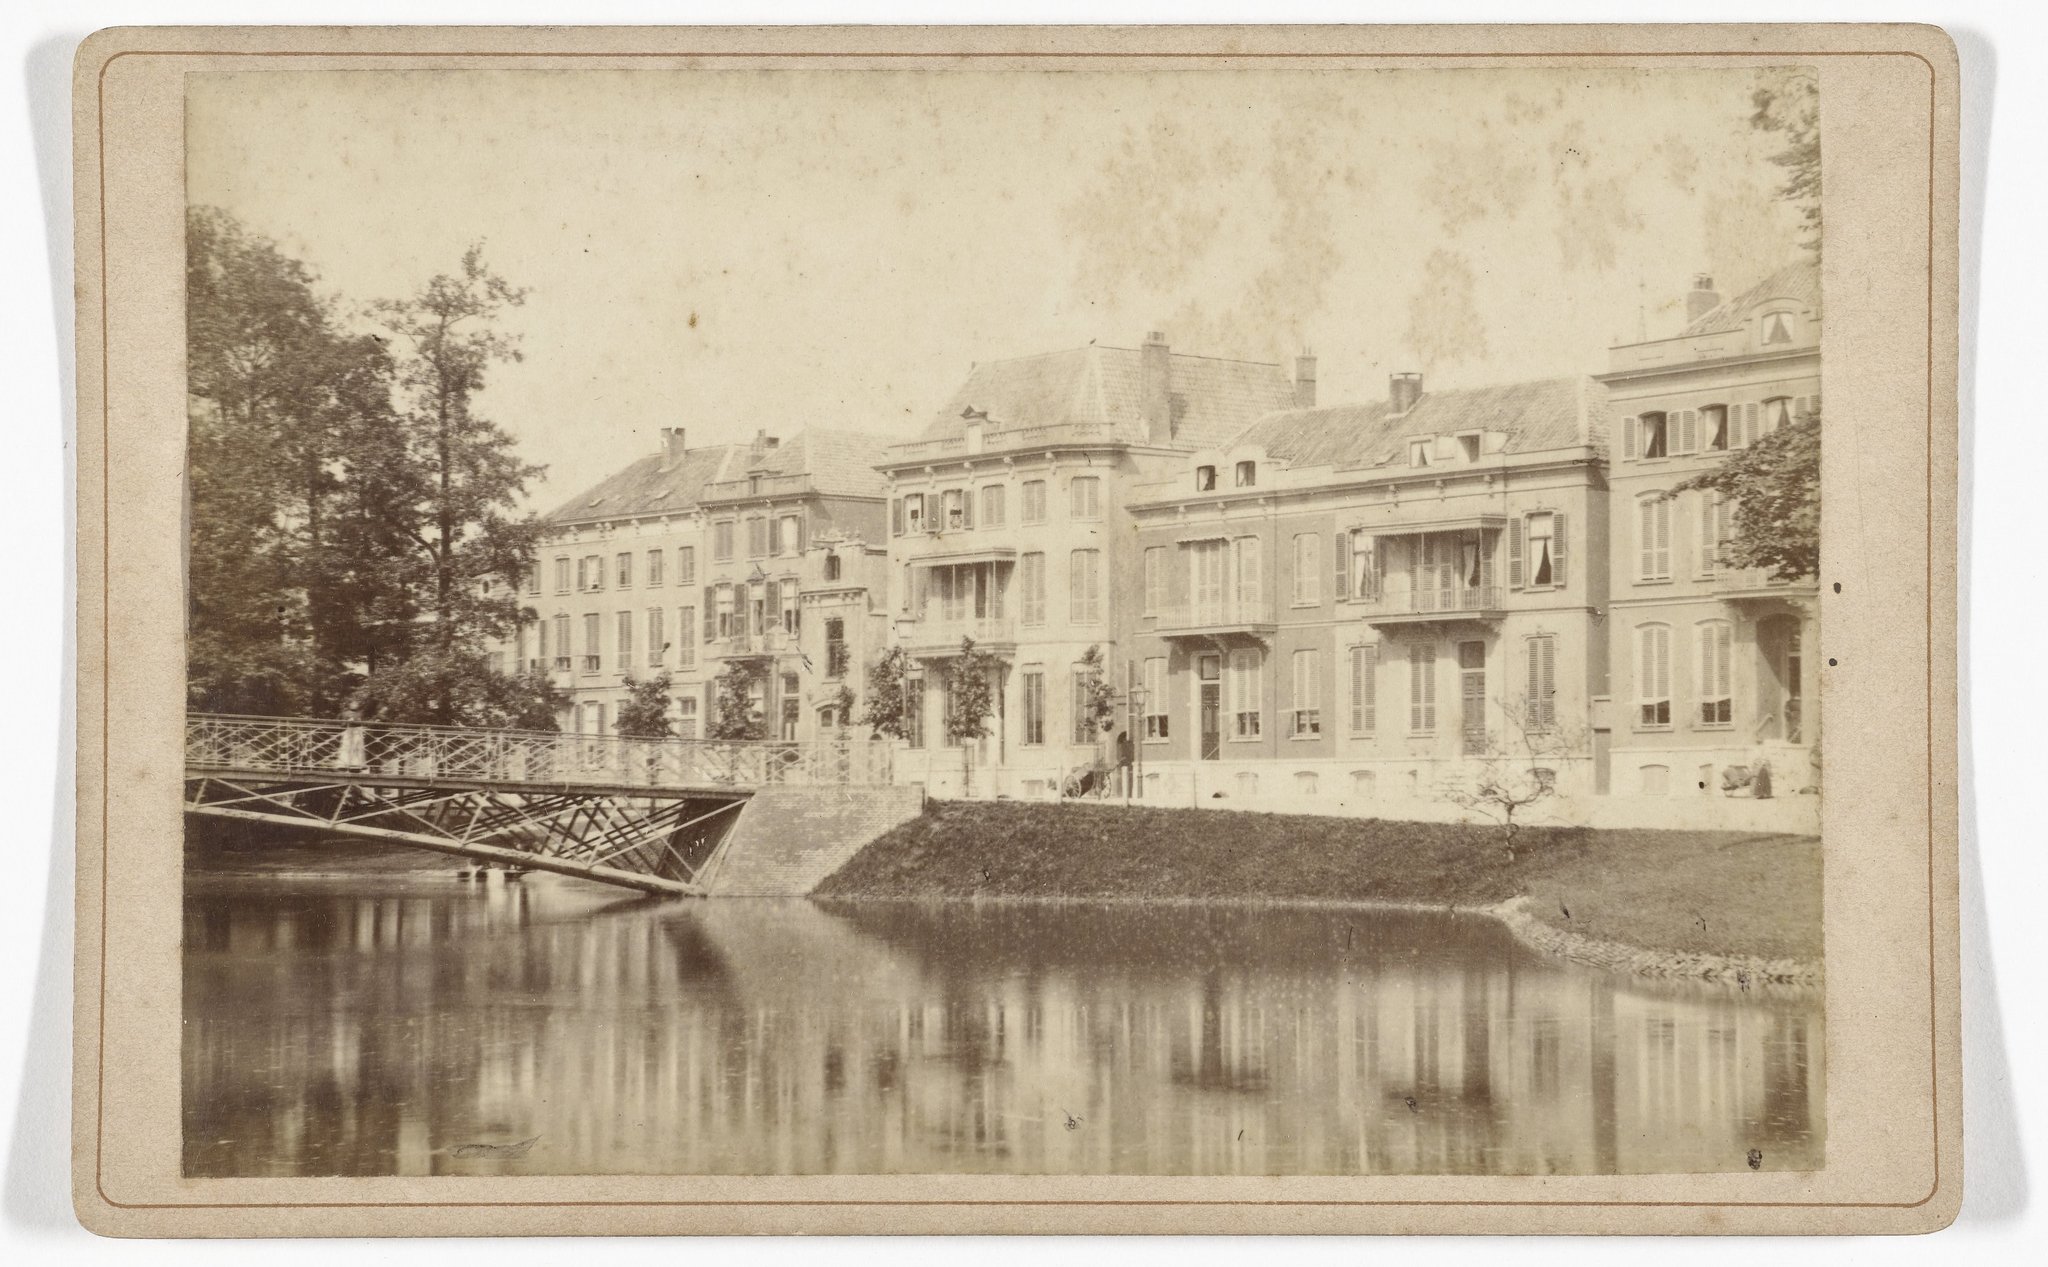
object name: photograph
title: Eusebius Buitensingel te Arnhem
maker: j.s.j. de jongh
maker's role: fotograaf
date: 1860-1890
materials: cardboard, paper, photographic support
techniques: albumen print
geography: arnhem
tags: canals, waters (in city), arnhem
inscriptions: annotation: ‘Arnhem. Eusebius Buitensingel.’, signature: ‘De Jongh, Koningsstraat 85 Arnhem’, signature: ‘Vosmaer’